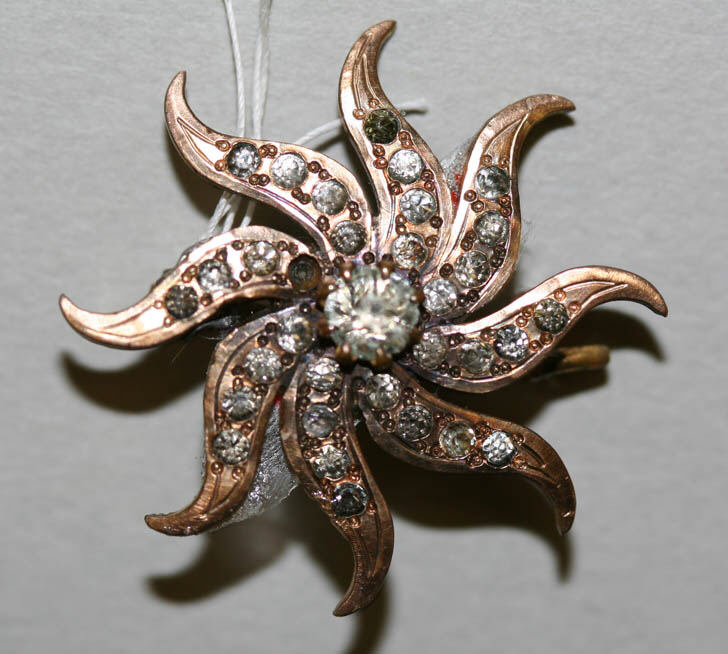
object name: pin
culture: american or european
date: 1867-1900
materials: glass, metal